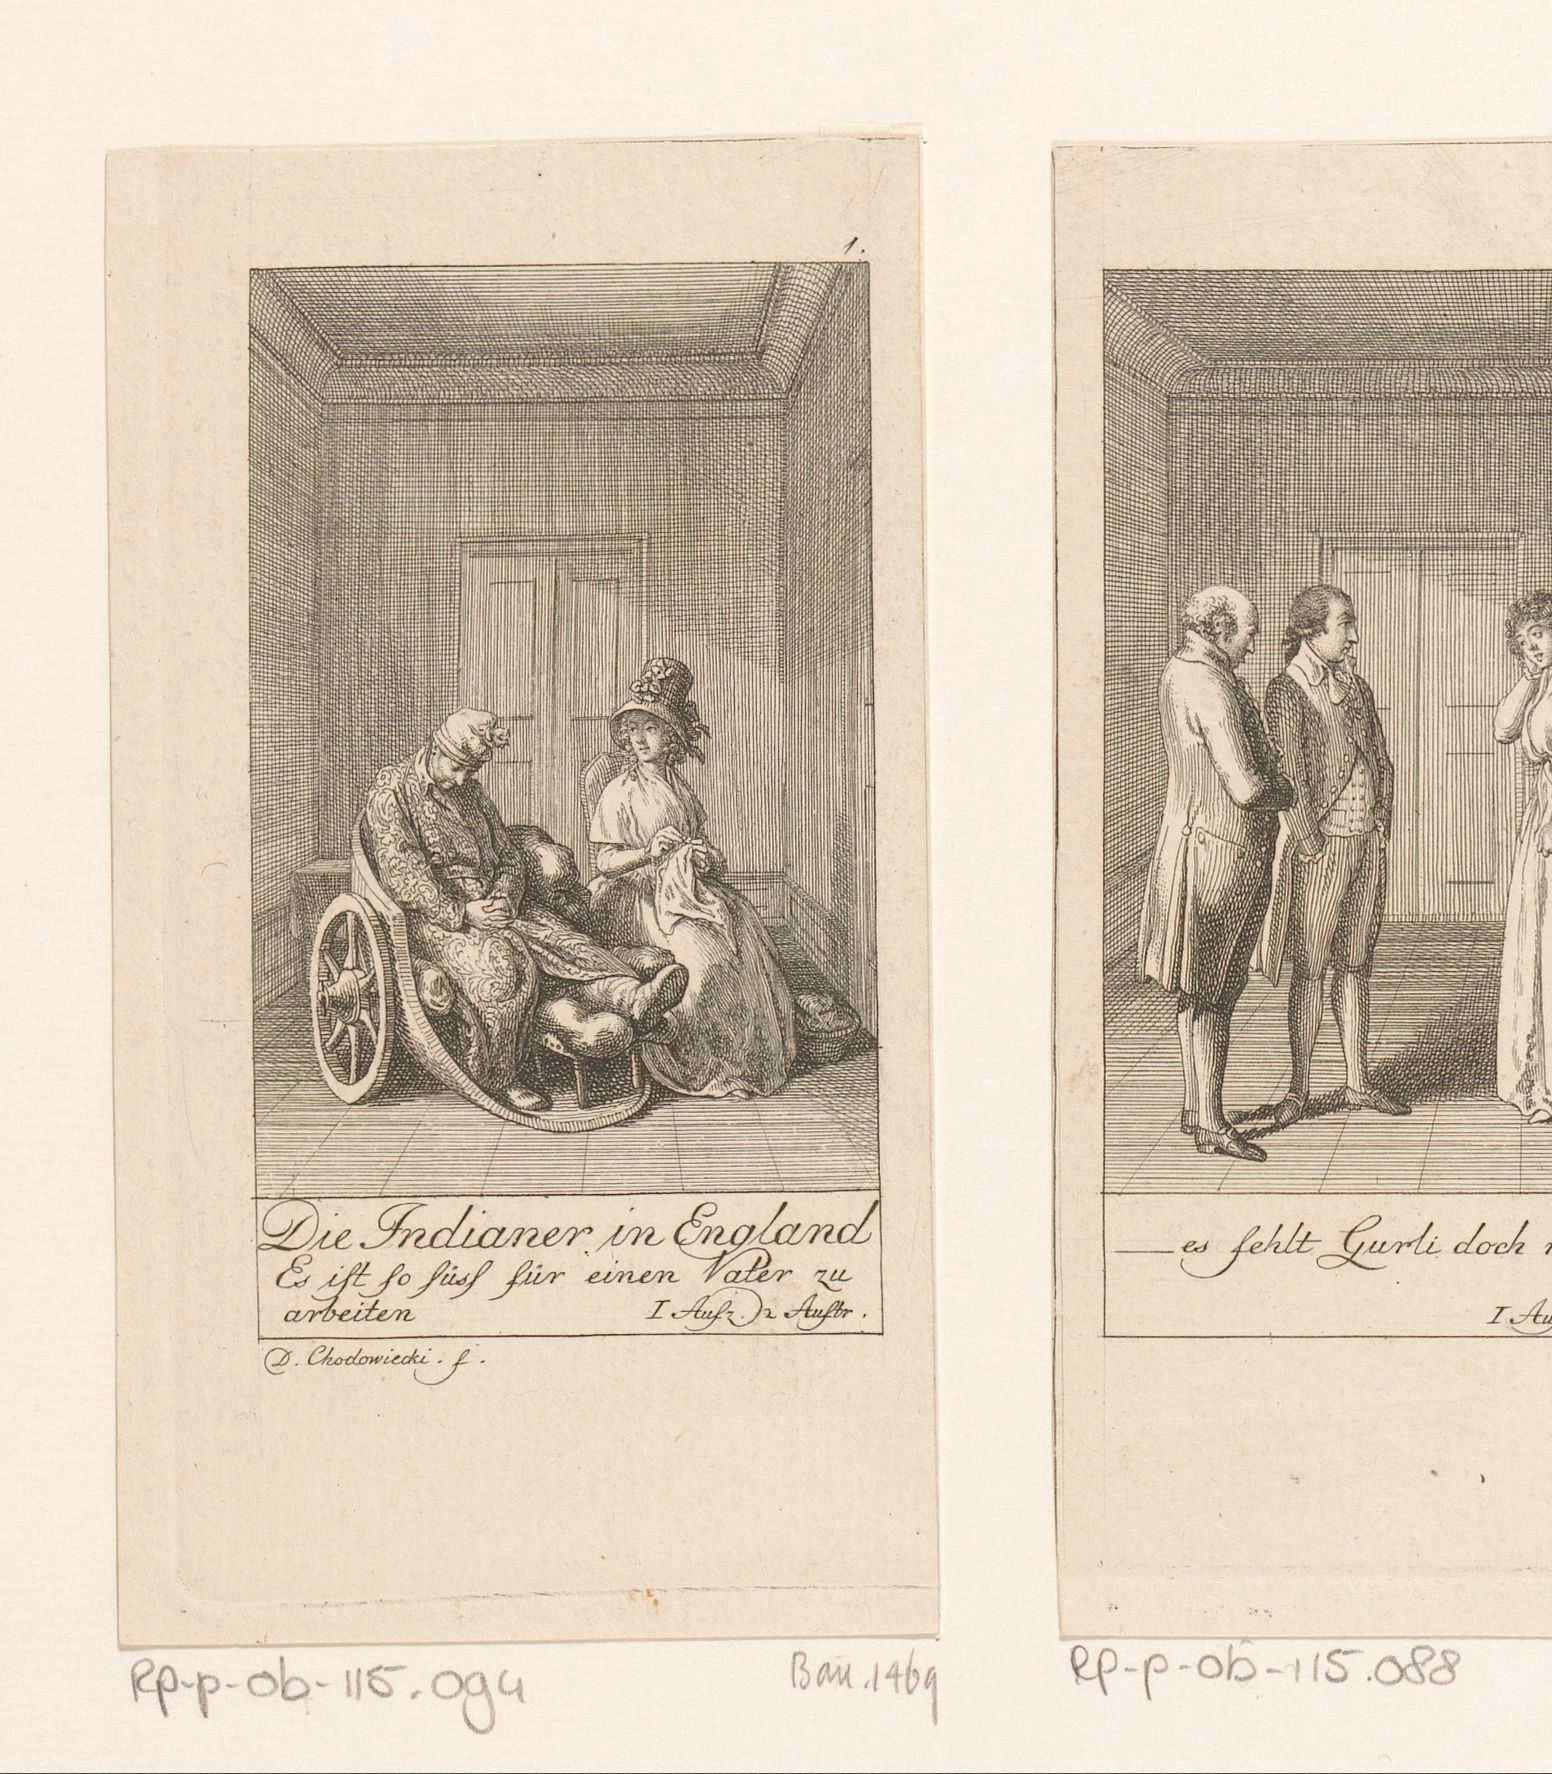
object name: print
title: Liddy in gesprek met Sir John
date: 1790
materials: paper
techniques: etching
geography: lauenburg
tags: literature, patient, sick person, conversation, dialogue; conversation piece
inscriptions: collector's mark: Lugt 2228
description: Vervaardigd voor 'De Indianen in Engeland' van August von Kotzebue. Prent gebruikt in: Königl. Grosbritannischer Historischer Genealogischer Calender für 1791. Lauenburg: Berenberg, [1790].